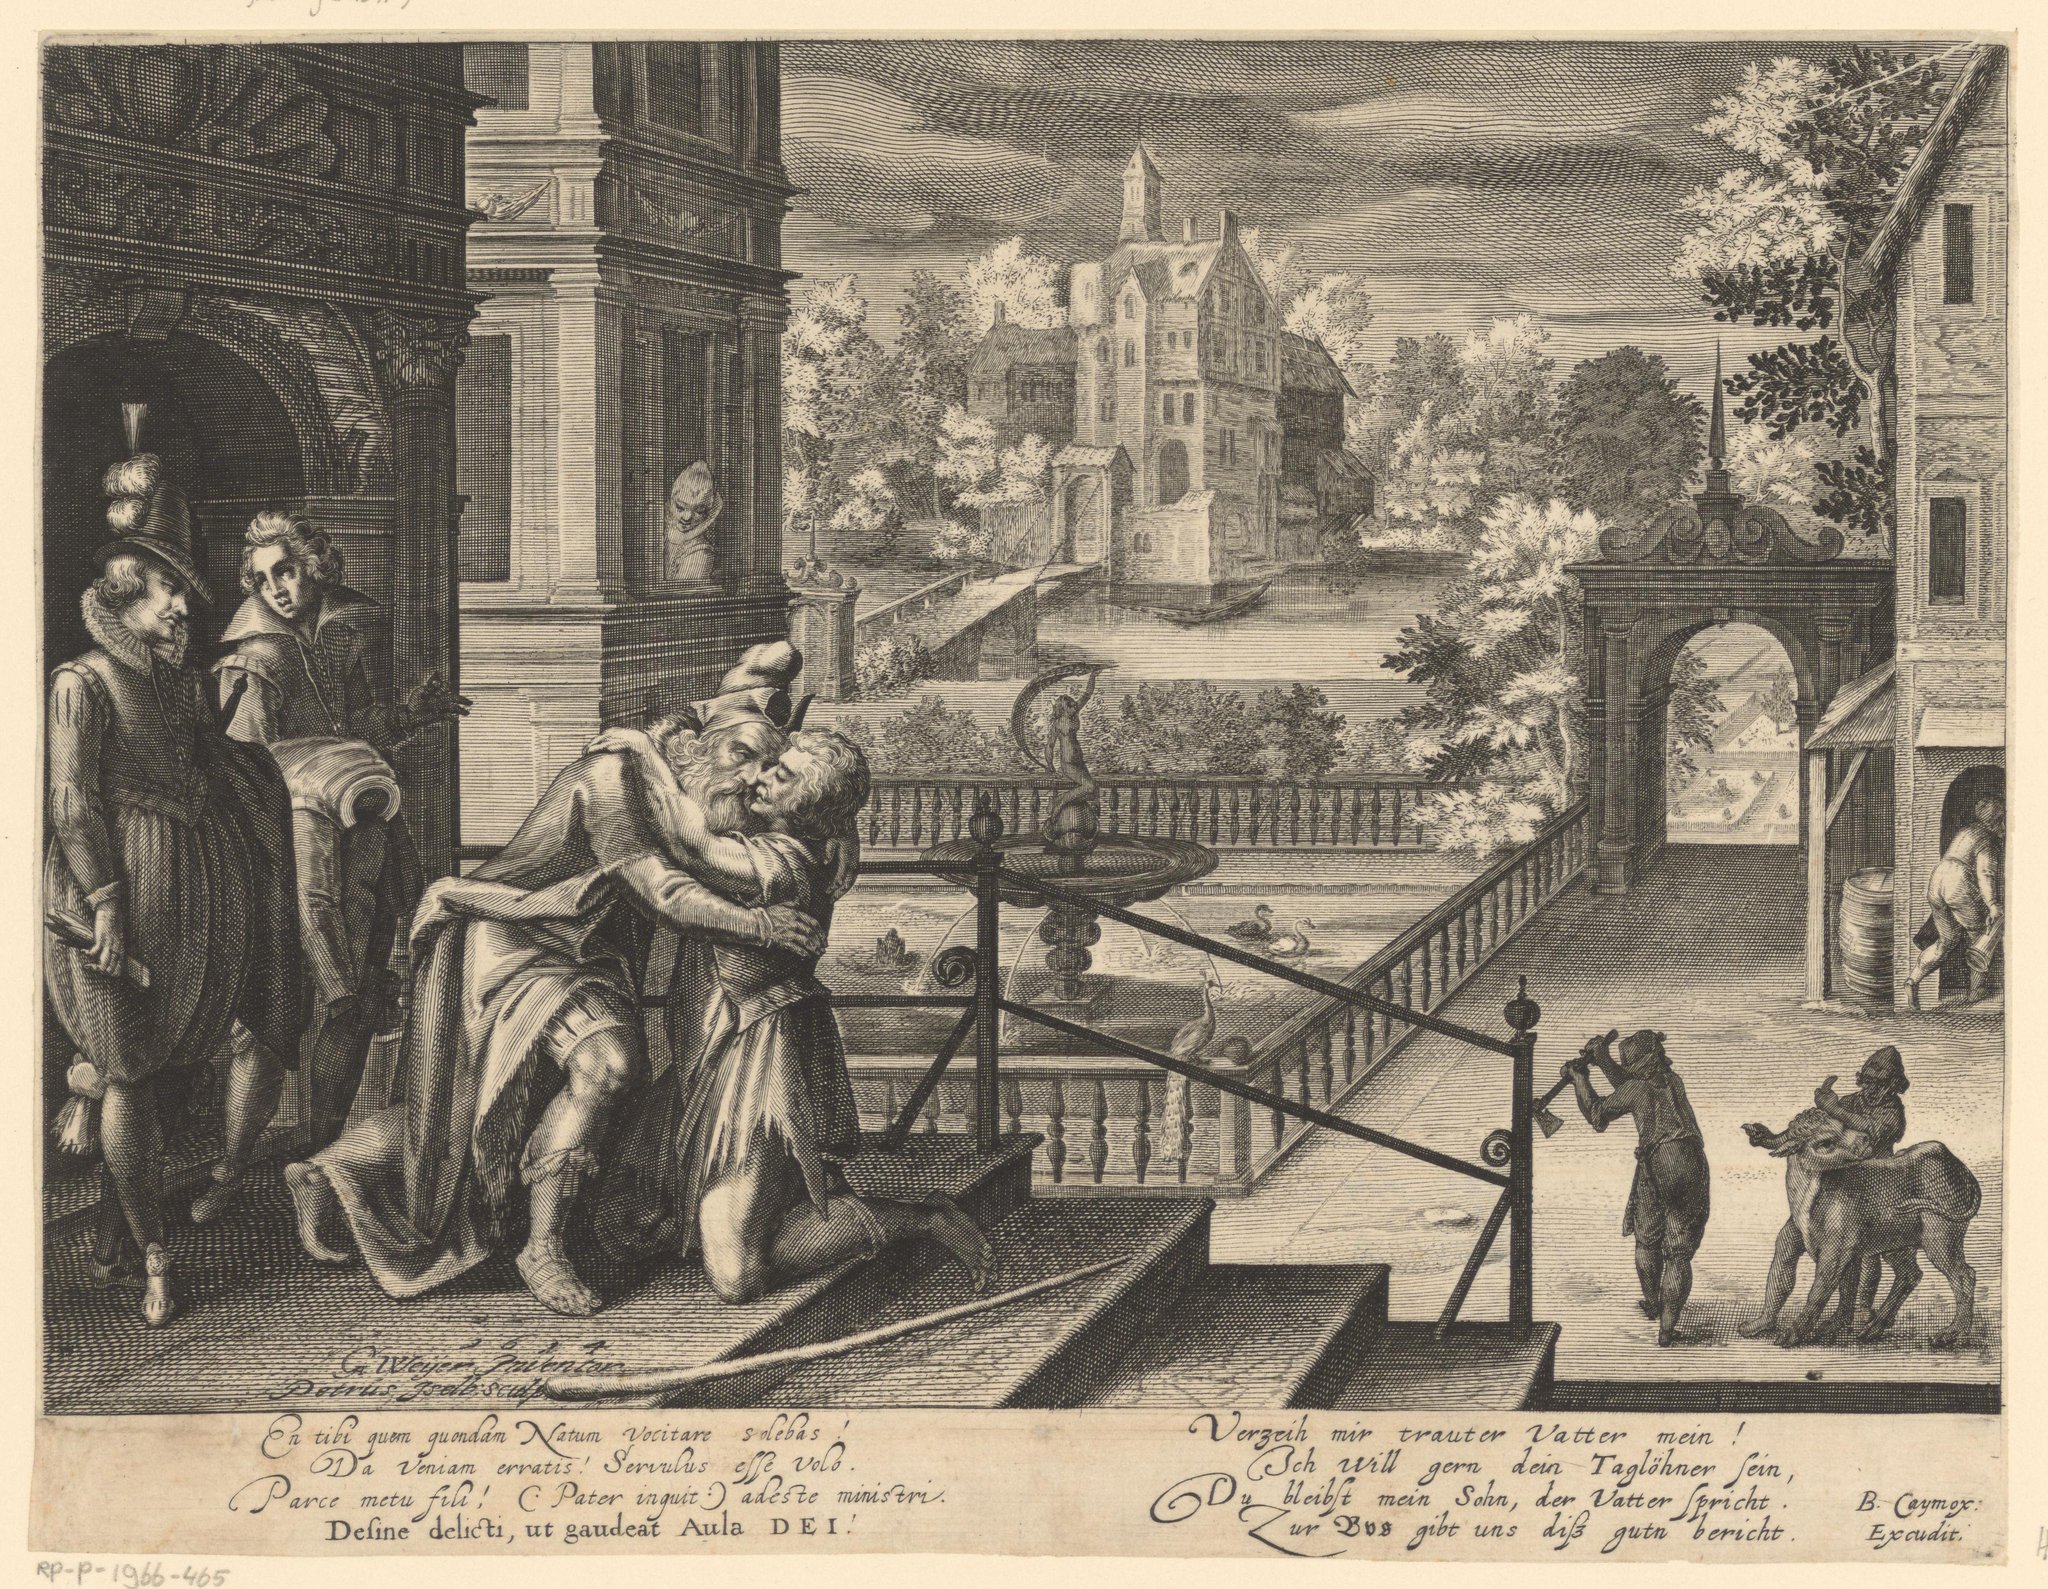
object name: print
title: Thuiskomst van de verloren zoon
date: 1614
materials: paper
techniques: engraving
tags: the prodigal son kneels before his father who takes him in his arms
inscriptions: collector's mark: Lugt 2228, collector's mark: Lugt 1041c